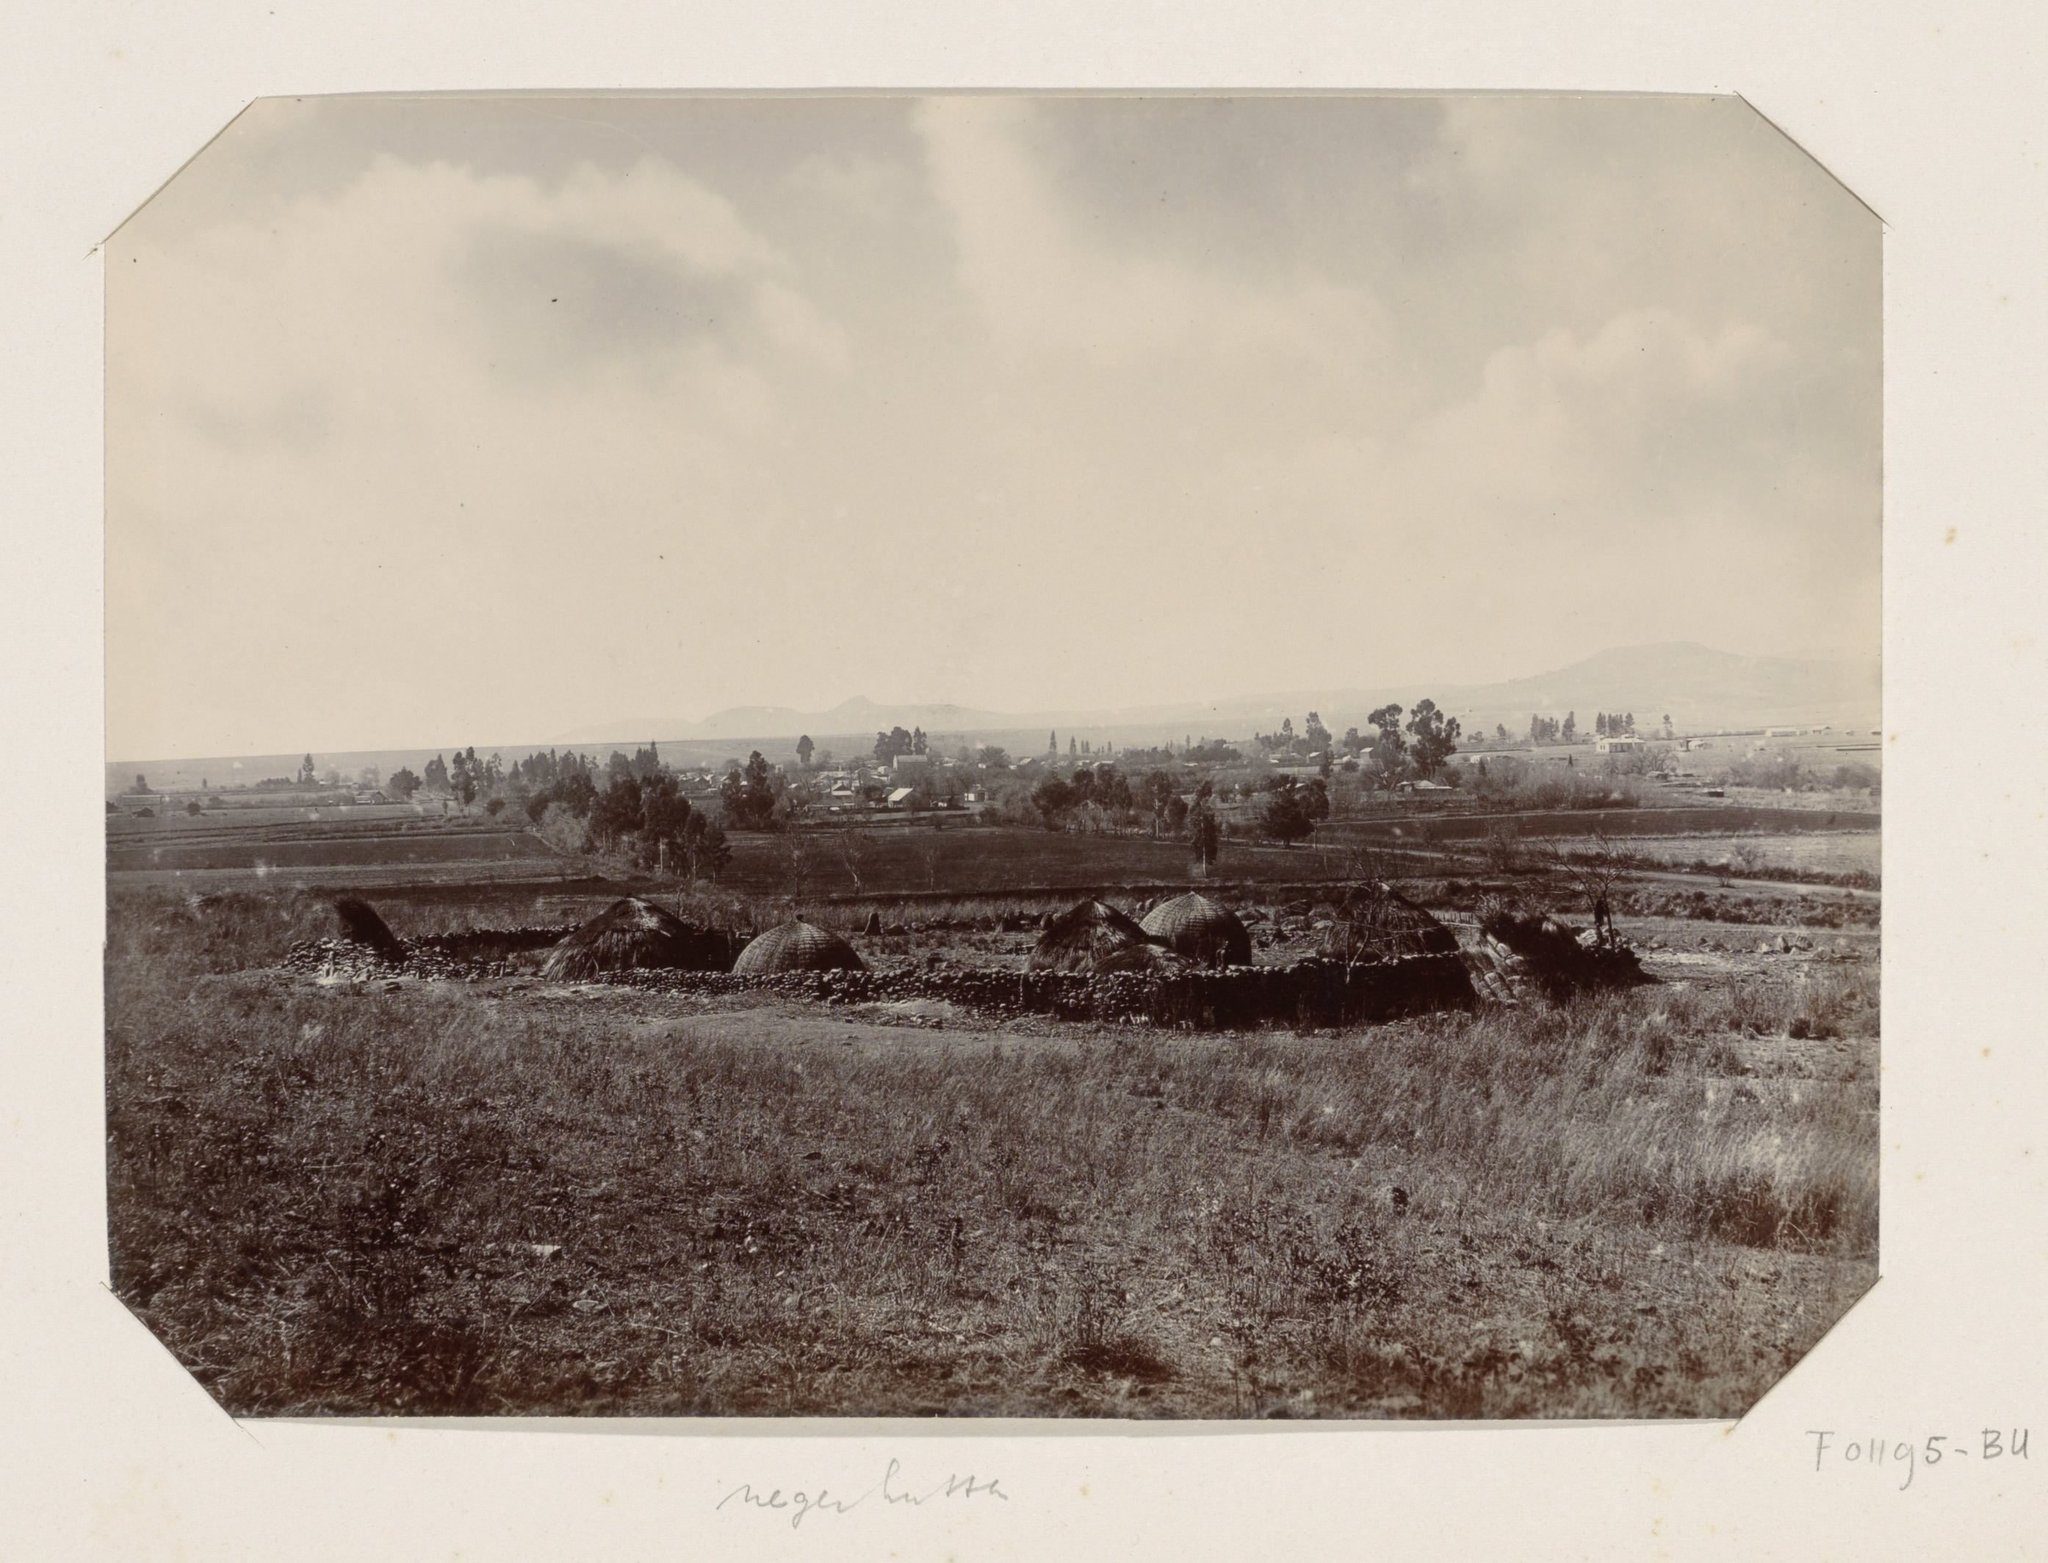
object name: photograph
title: Gezicht op een dorp met op de voorgrond hutten, vermoedelijk in Zuid-Afrika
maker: Anonymous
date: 1890-1920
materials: cardboard, paper, photographic support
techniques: gelatin silver print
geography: south africa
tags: zuid-afrika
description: Onderdeel van Fotoalbum van een reis door de Verenigde Staten, Honolulu, Nederlands-Indië, Aden, Zanzibar en Zuidelijk Afrika.